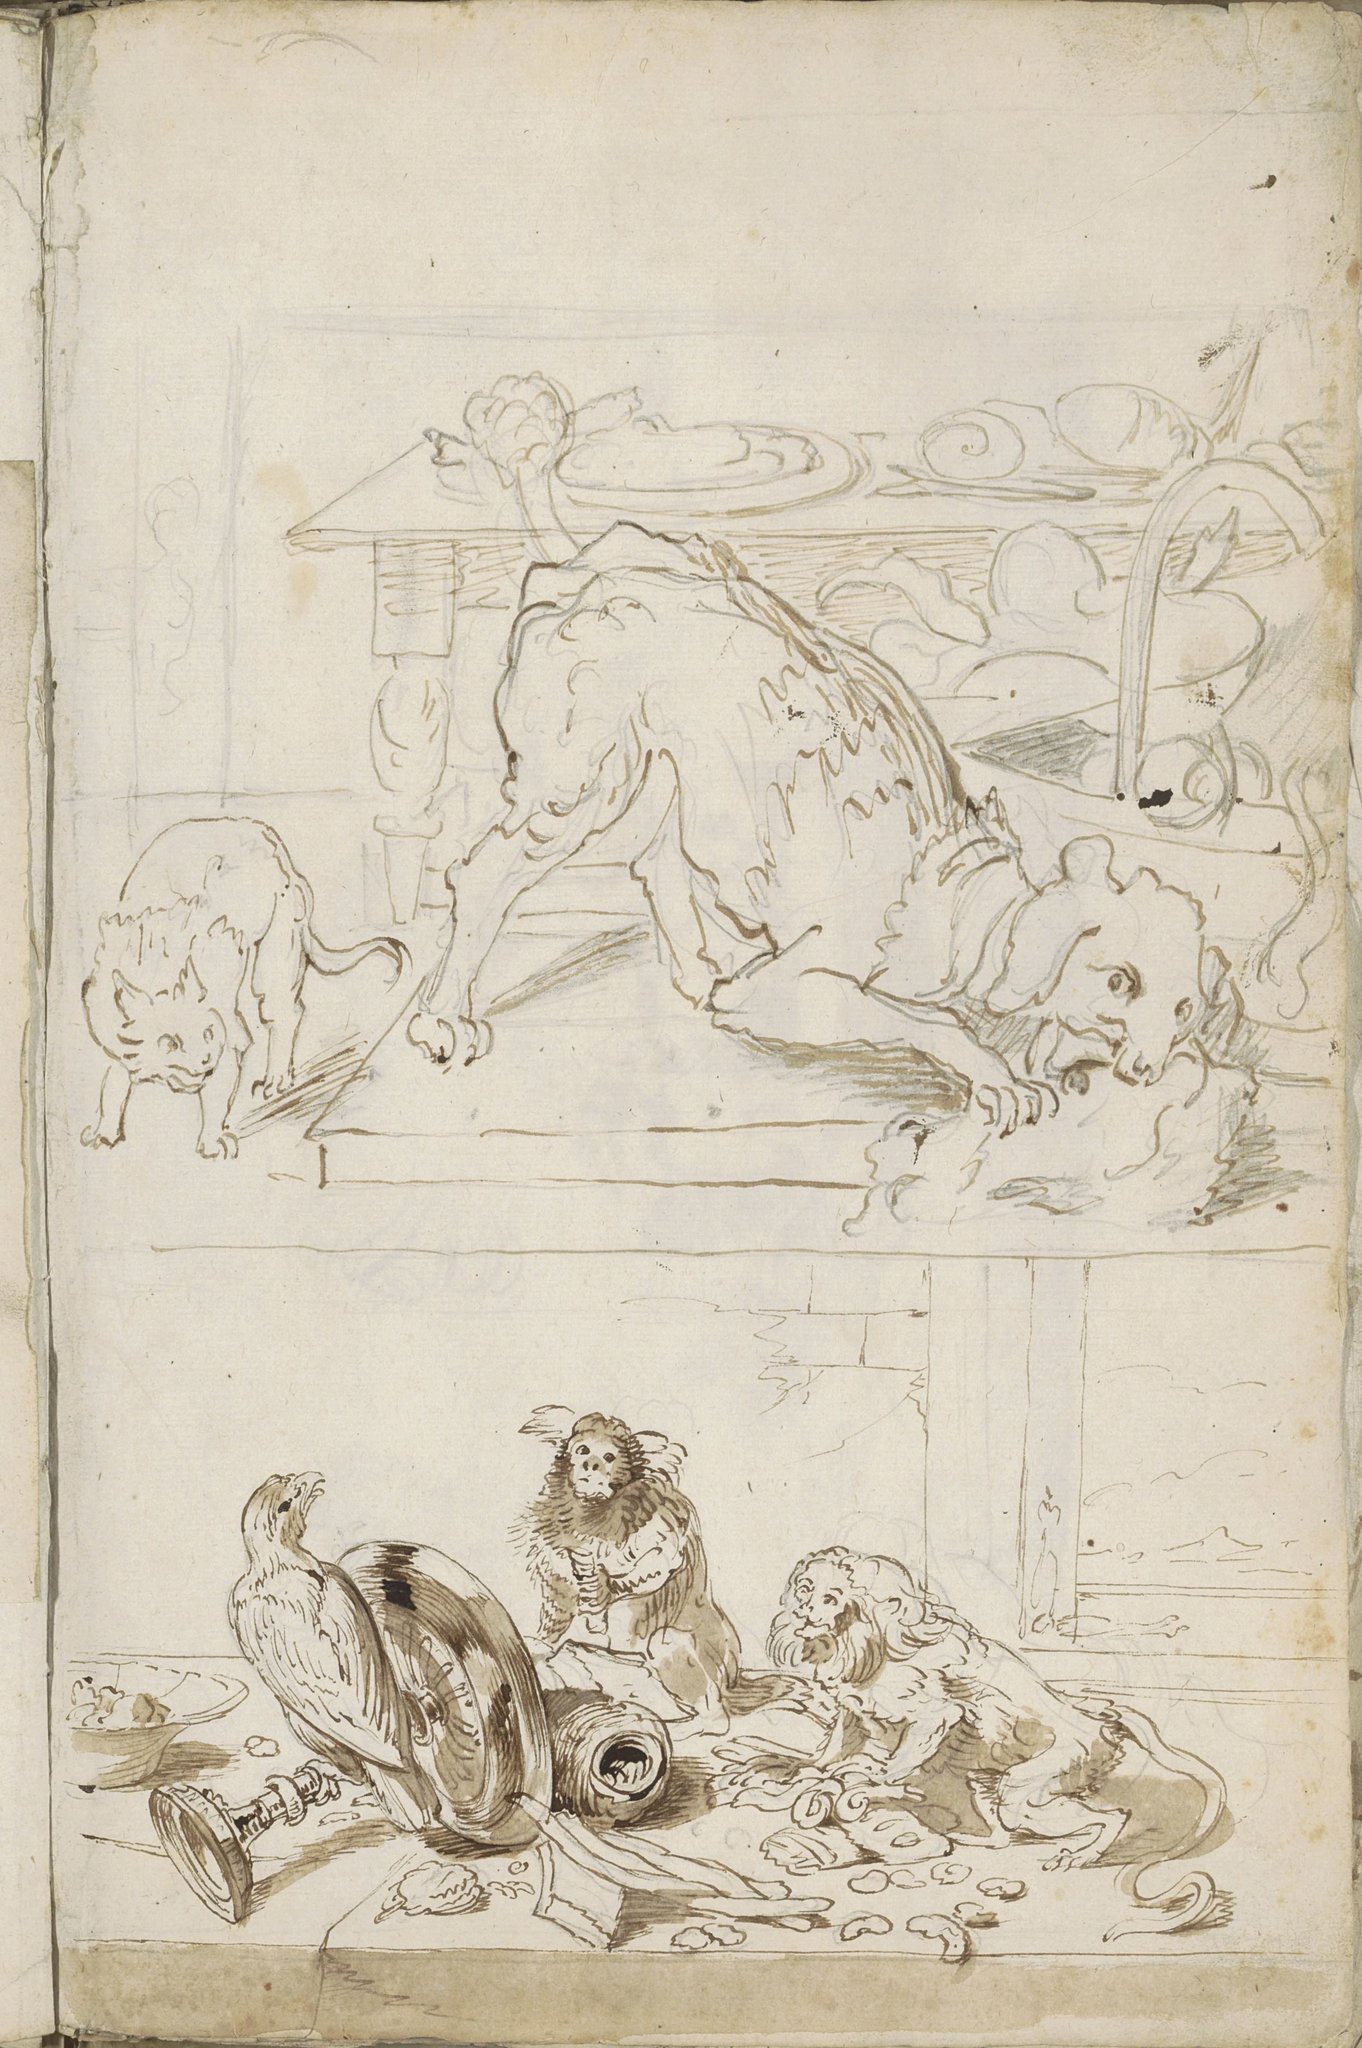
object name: sketchbook leaf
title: Twee dierstukken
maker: paul de vos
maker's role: draughtsman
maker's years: 1595-1678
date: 1605-1678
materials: ink, paper, pencil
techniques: brush, pen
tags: cat, interior of the house, dog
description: Scène met kat die naar een hond blaast die een stuk voedsel eet bij een keukentafel. Tevens een studie van twee apen en een vogel die een een vaas, schaal en diverse kleinere voorwerpen op een tafel hebben omgegooid. Blad 7 recto uit een schetsboek met 15 bladen.